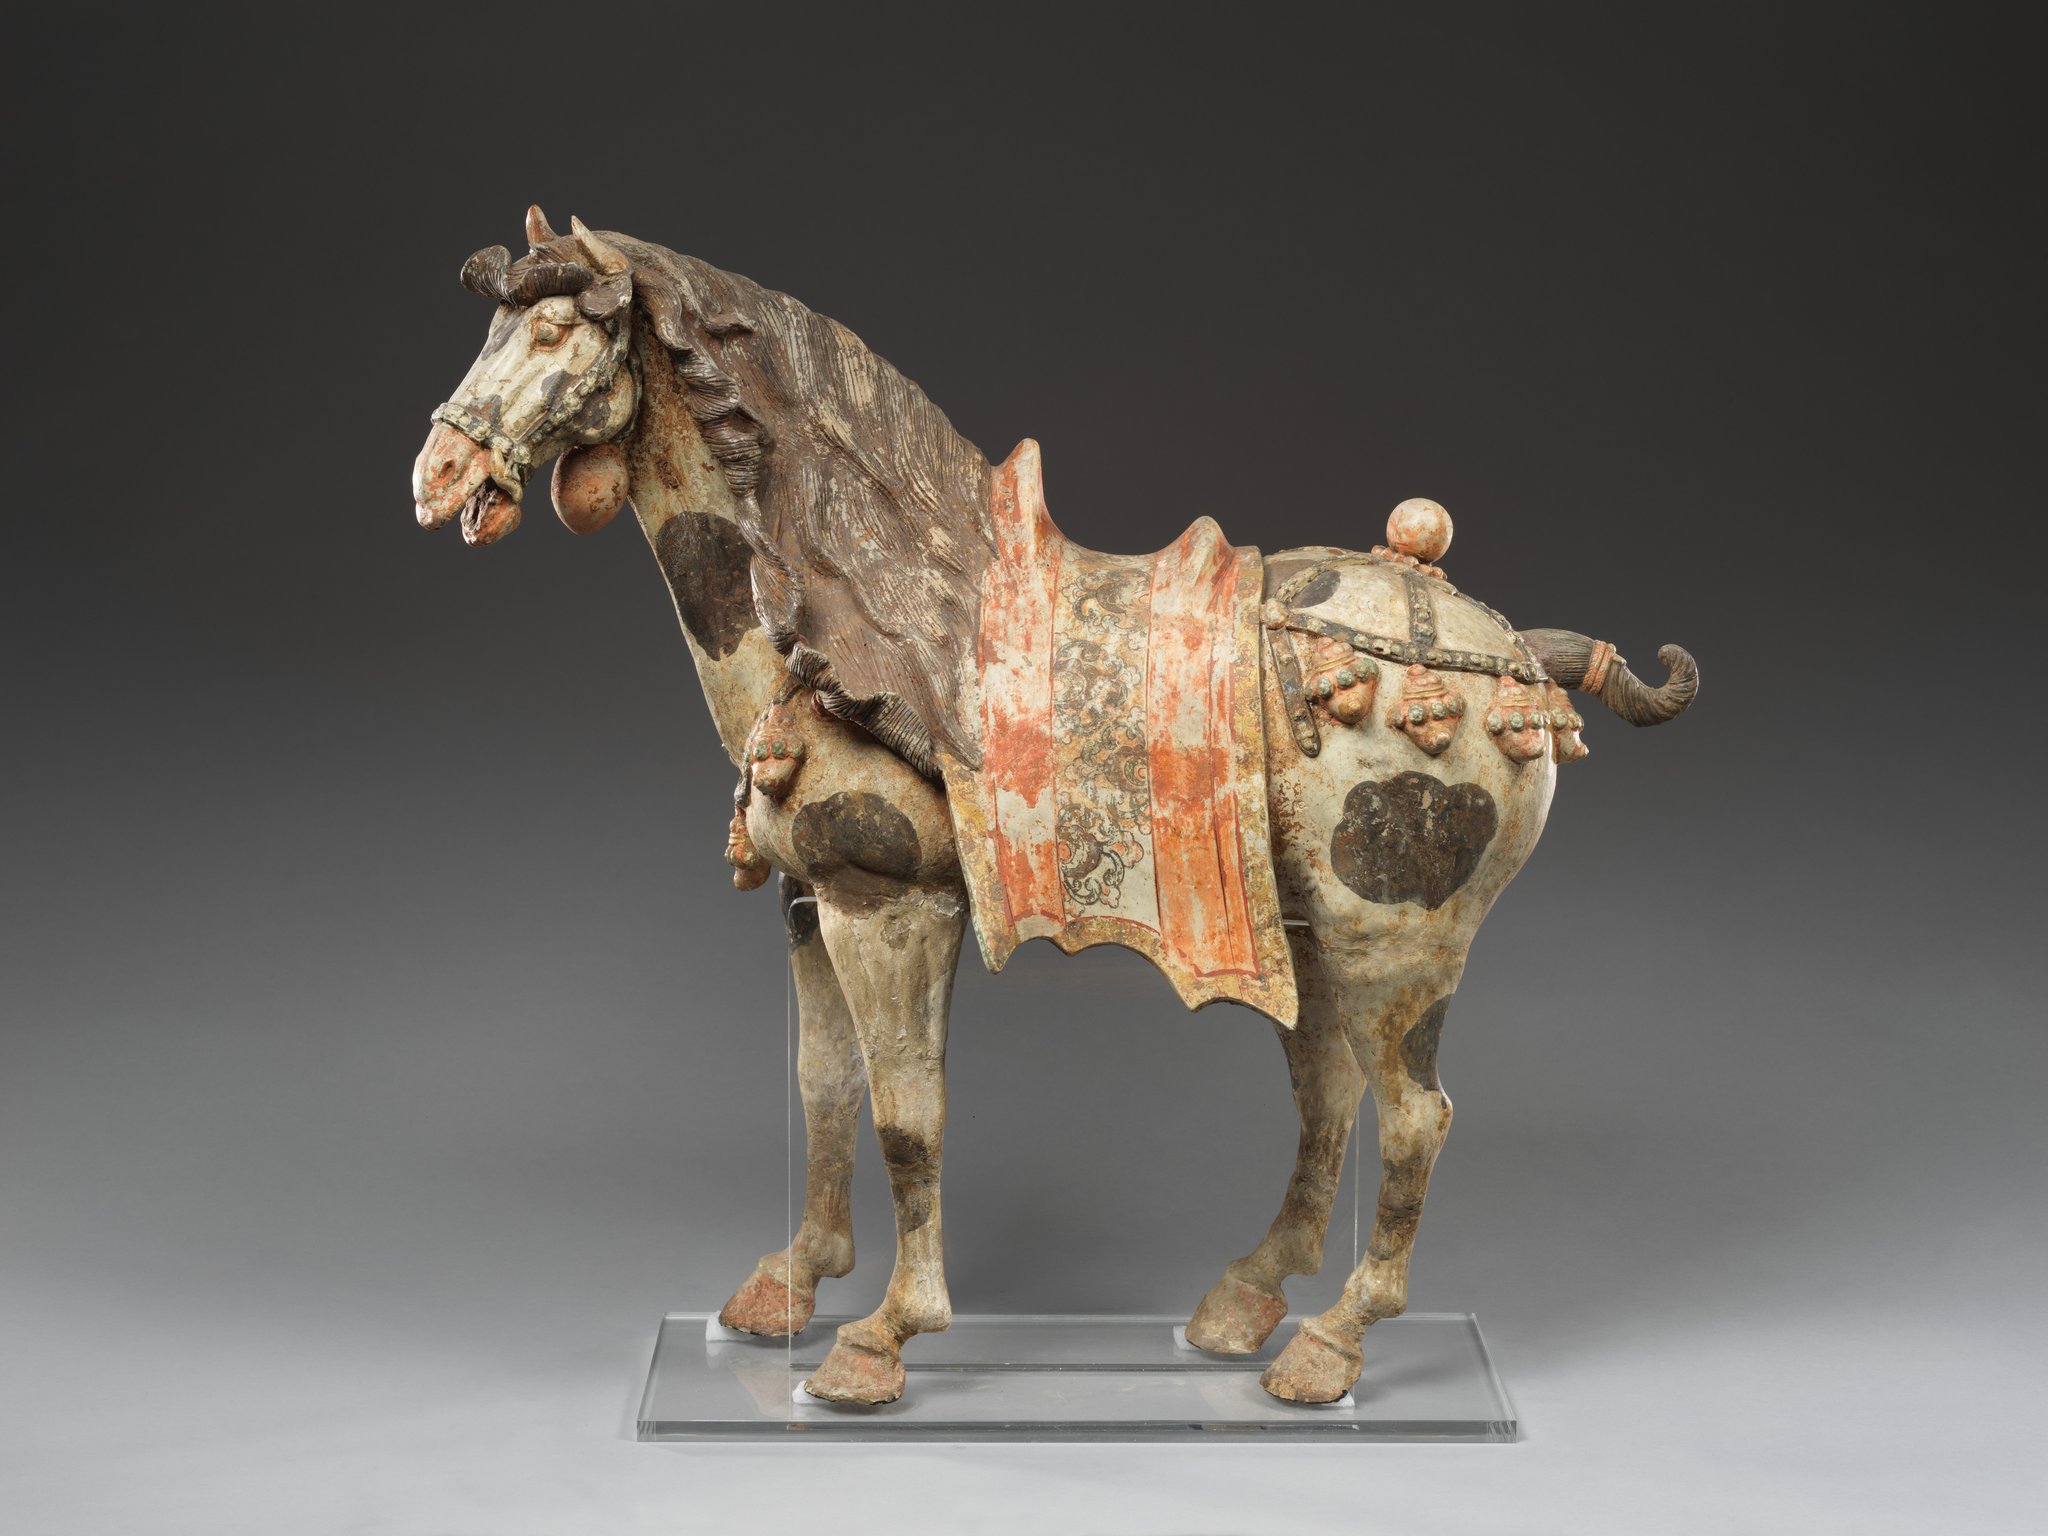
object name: figure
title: Horse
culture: chinese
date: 667-733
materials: earthenware, pigment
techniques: gilding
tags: horses